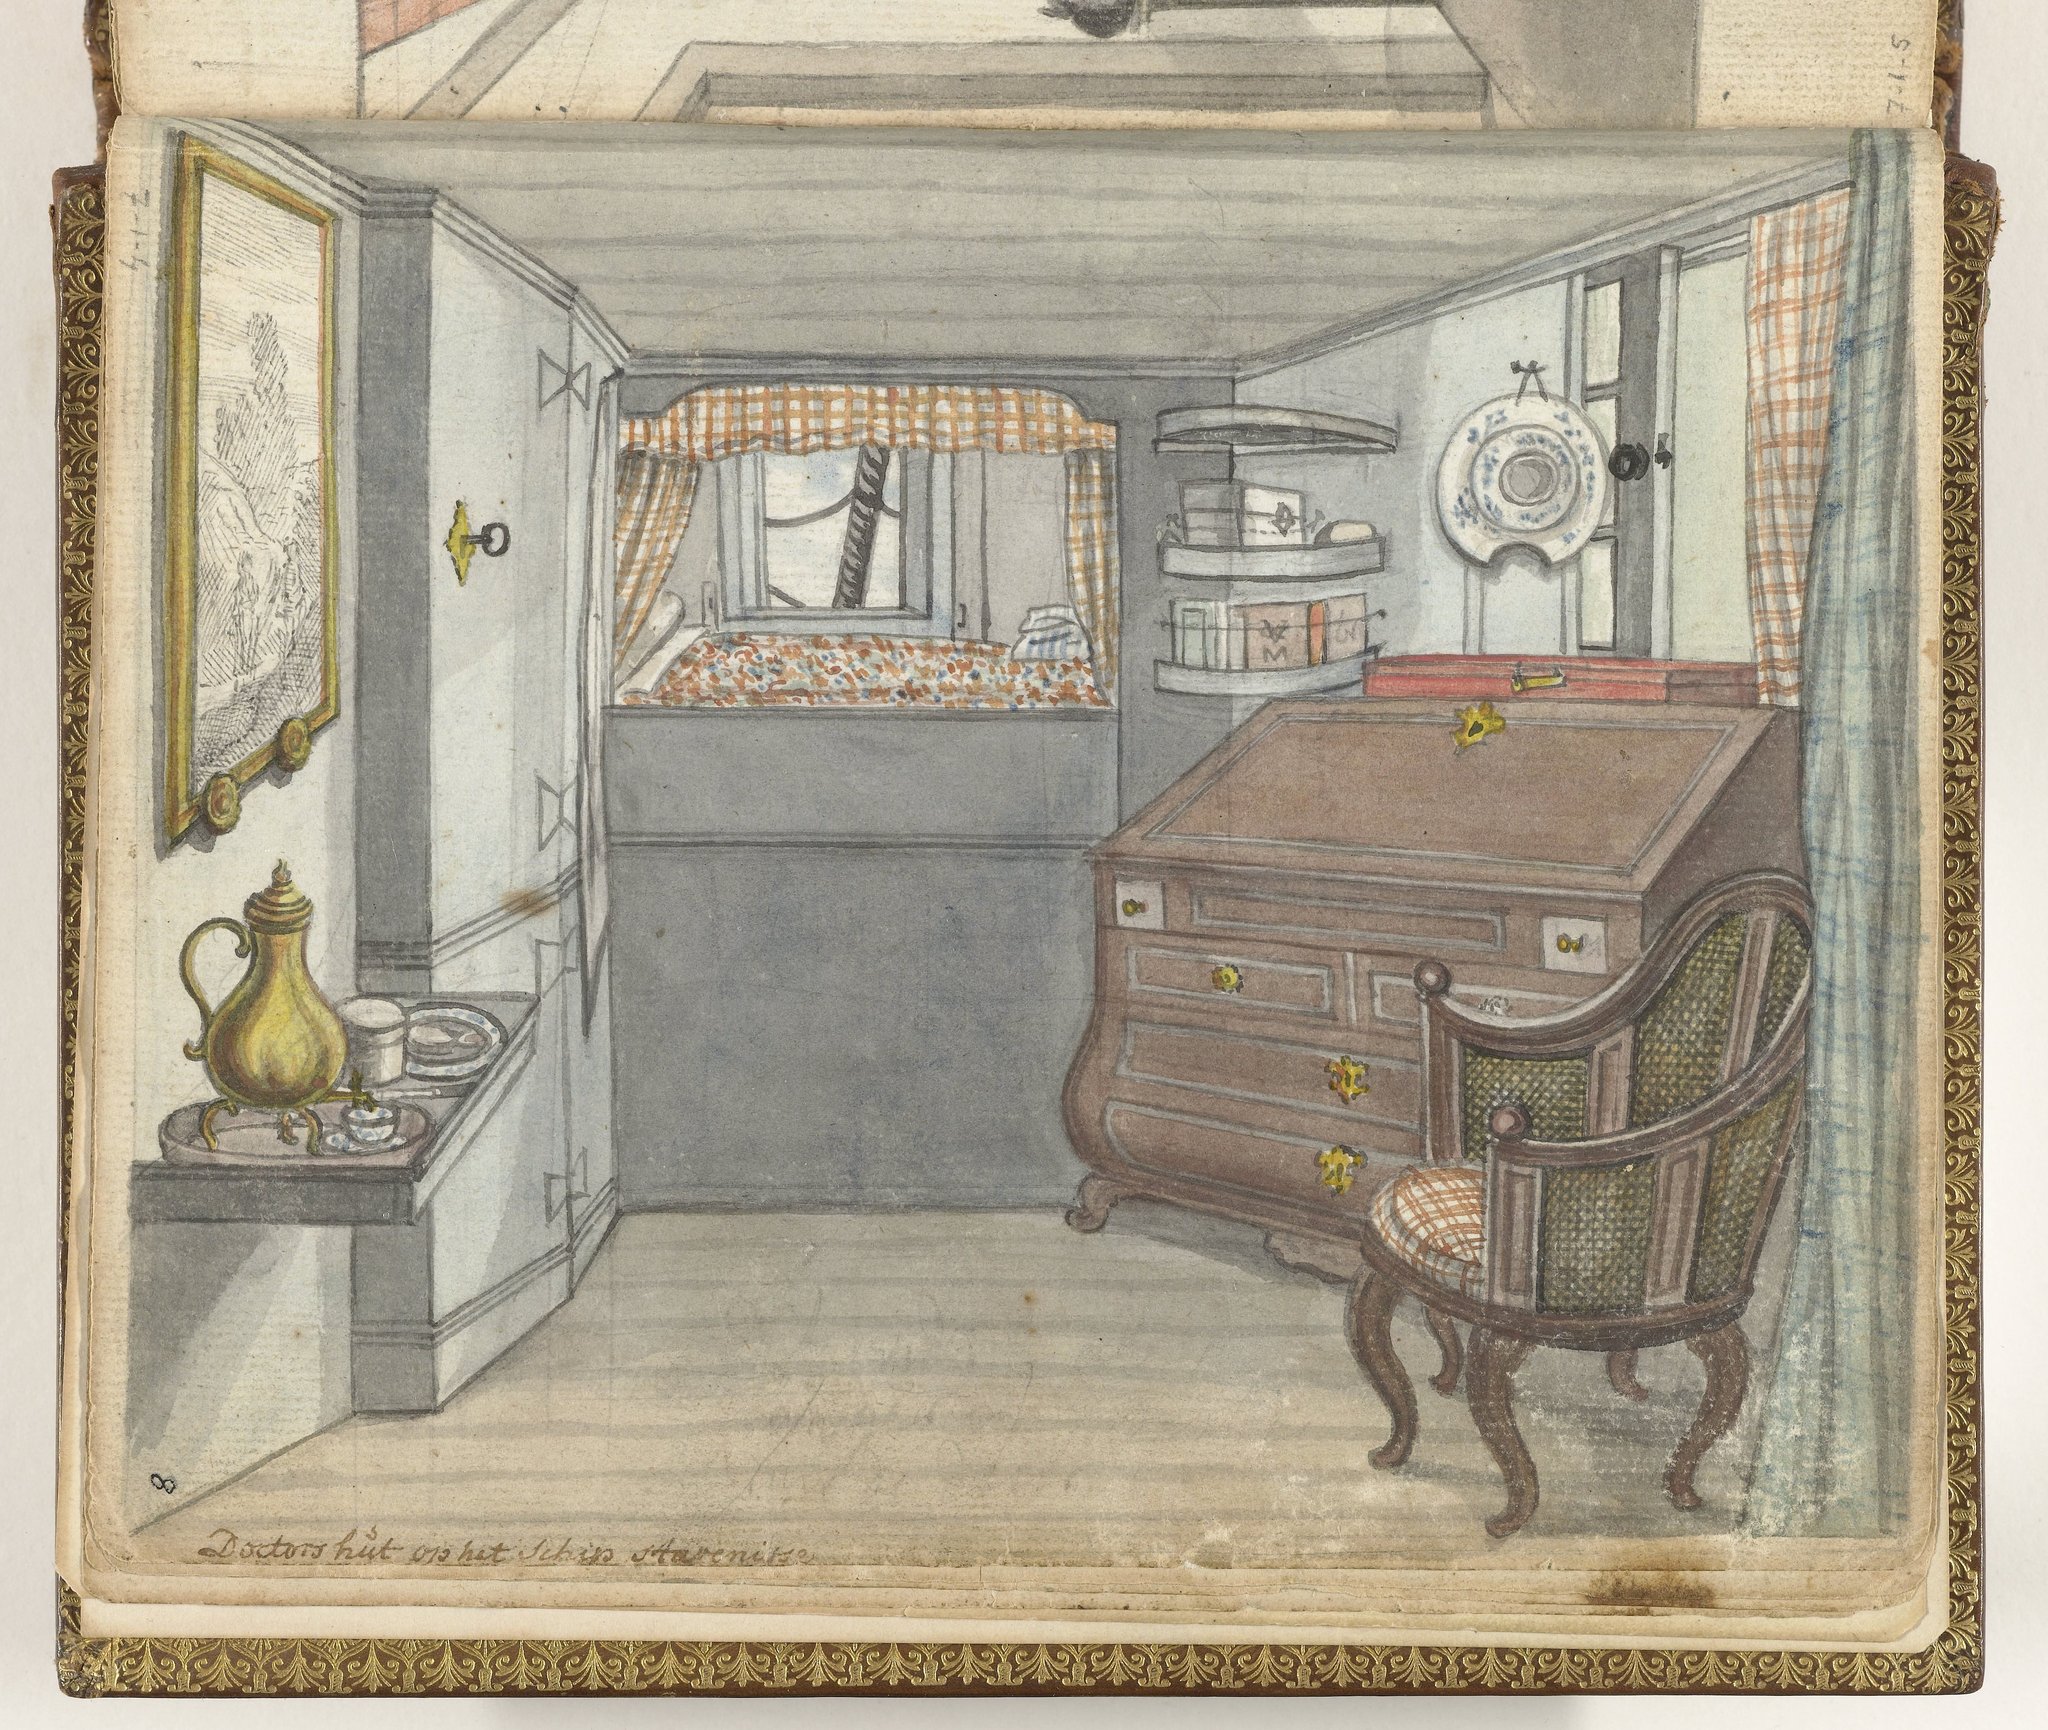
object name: drawing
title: Hut van de chirurgijn op het VOC-schip de Stavenisse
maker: jan brandes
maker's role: draughtsman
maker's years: 1743-1808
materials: paper, pencil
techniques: brush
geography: indian ocean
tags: bodegraven, draughtsman, jan brandes, parts of ship's interior (cabin), barber; surgeon, middelburg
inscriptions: inscription: ‘Doctors hut op het schip Stavenisse’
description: Interieur in matig perspectief van een scheepshut. Het verre punt in de tekening ligt in een te klein getekende scheepskooi met beddengoed en afgeschoten met ruitgordijntjes. Door een patrijspoort is een stuk want zichtbaar. De hut is vrij uitgebreid ingericht. Links hangt een schilderij of prent aan de wand. Daaronder staat een koffieservies. Rechts voor staat een stoel voor een commode. Daarboven hangt een scheerbekken. Rechts van de kooi plankjes met boeken. Op één: VOCM, van de VOC-kamer Middelburg. Met opschrift. Onderdeel uit het schetsboek van Jan Brandes, dl. 1 (1808), p. 8.